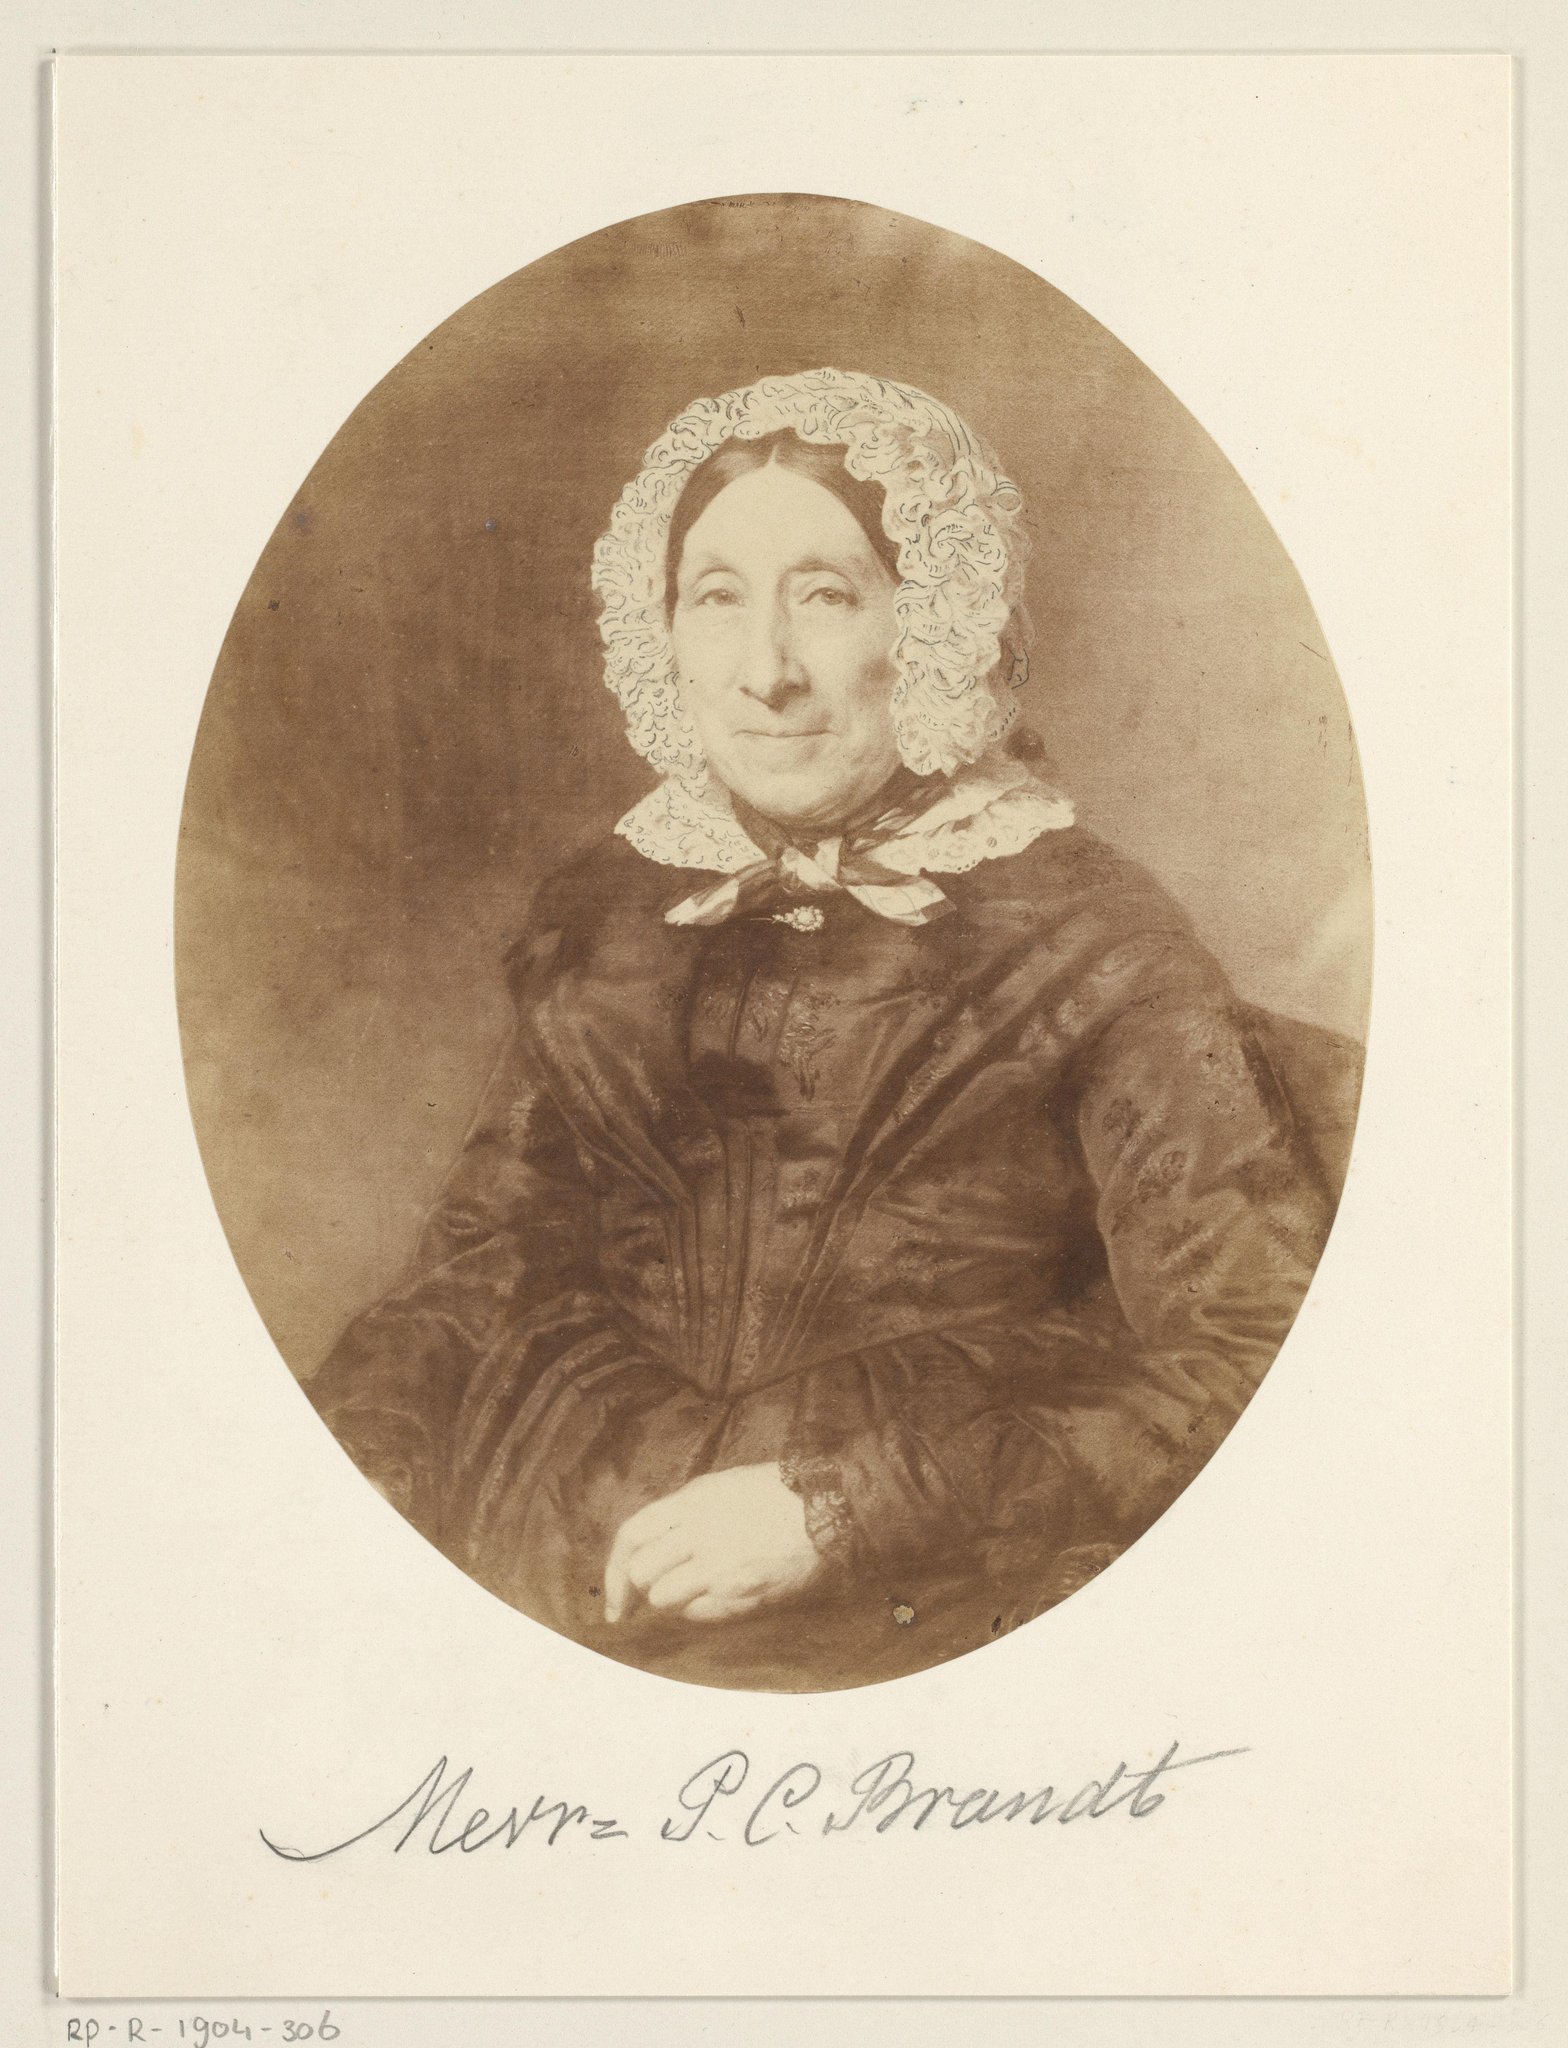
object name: photograph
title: Fotoreproductie van een geschilderd portret van Petronella Catharina Brandt-Kersting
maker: Anonymous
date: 1892-1900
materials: cardboard, paper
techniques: albumen print, retouching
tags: amsterdam, historical persons - bb - woman, old woman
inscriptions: collector's mark: Lugt 2228, inscription: ‘Mevr. P.C. Brandt’, number: ‘'04. 306’